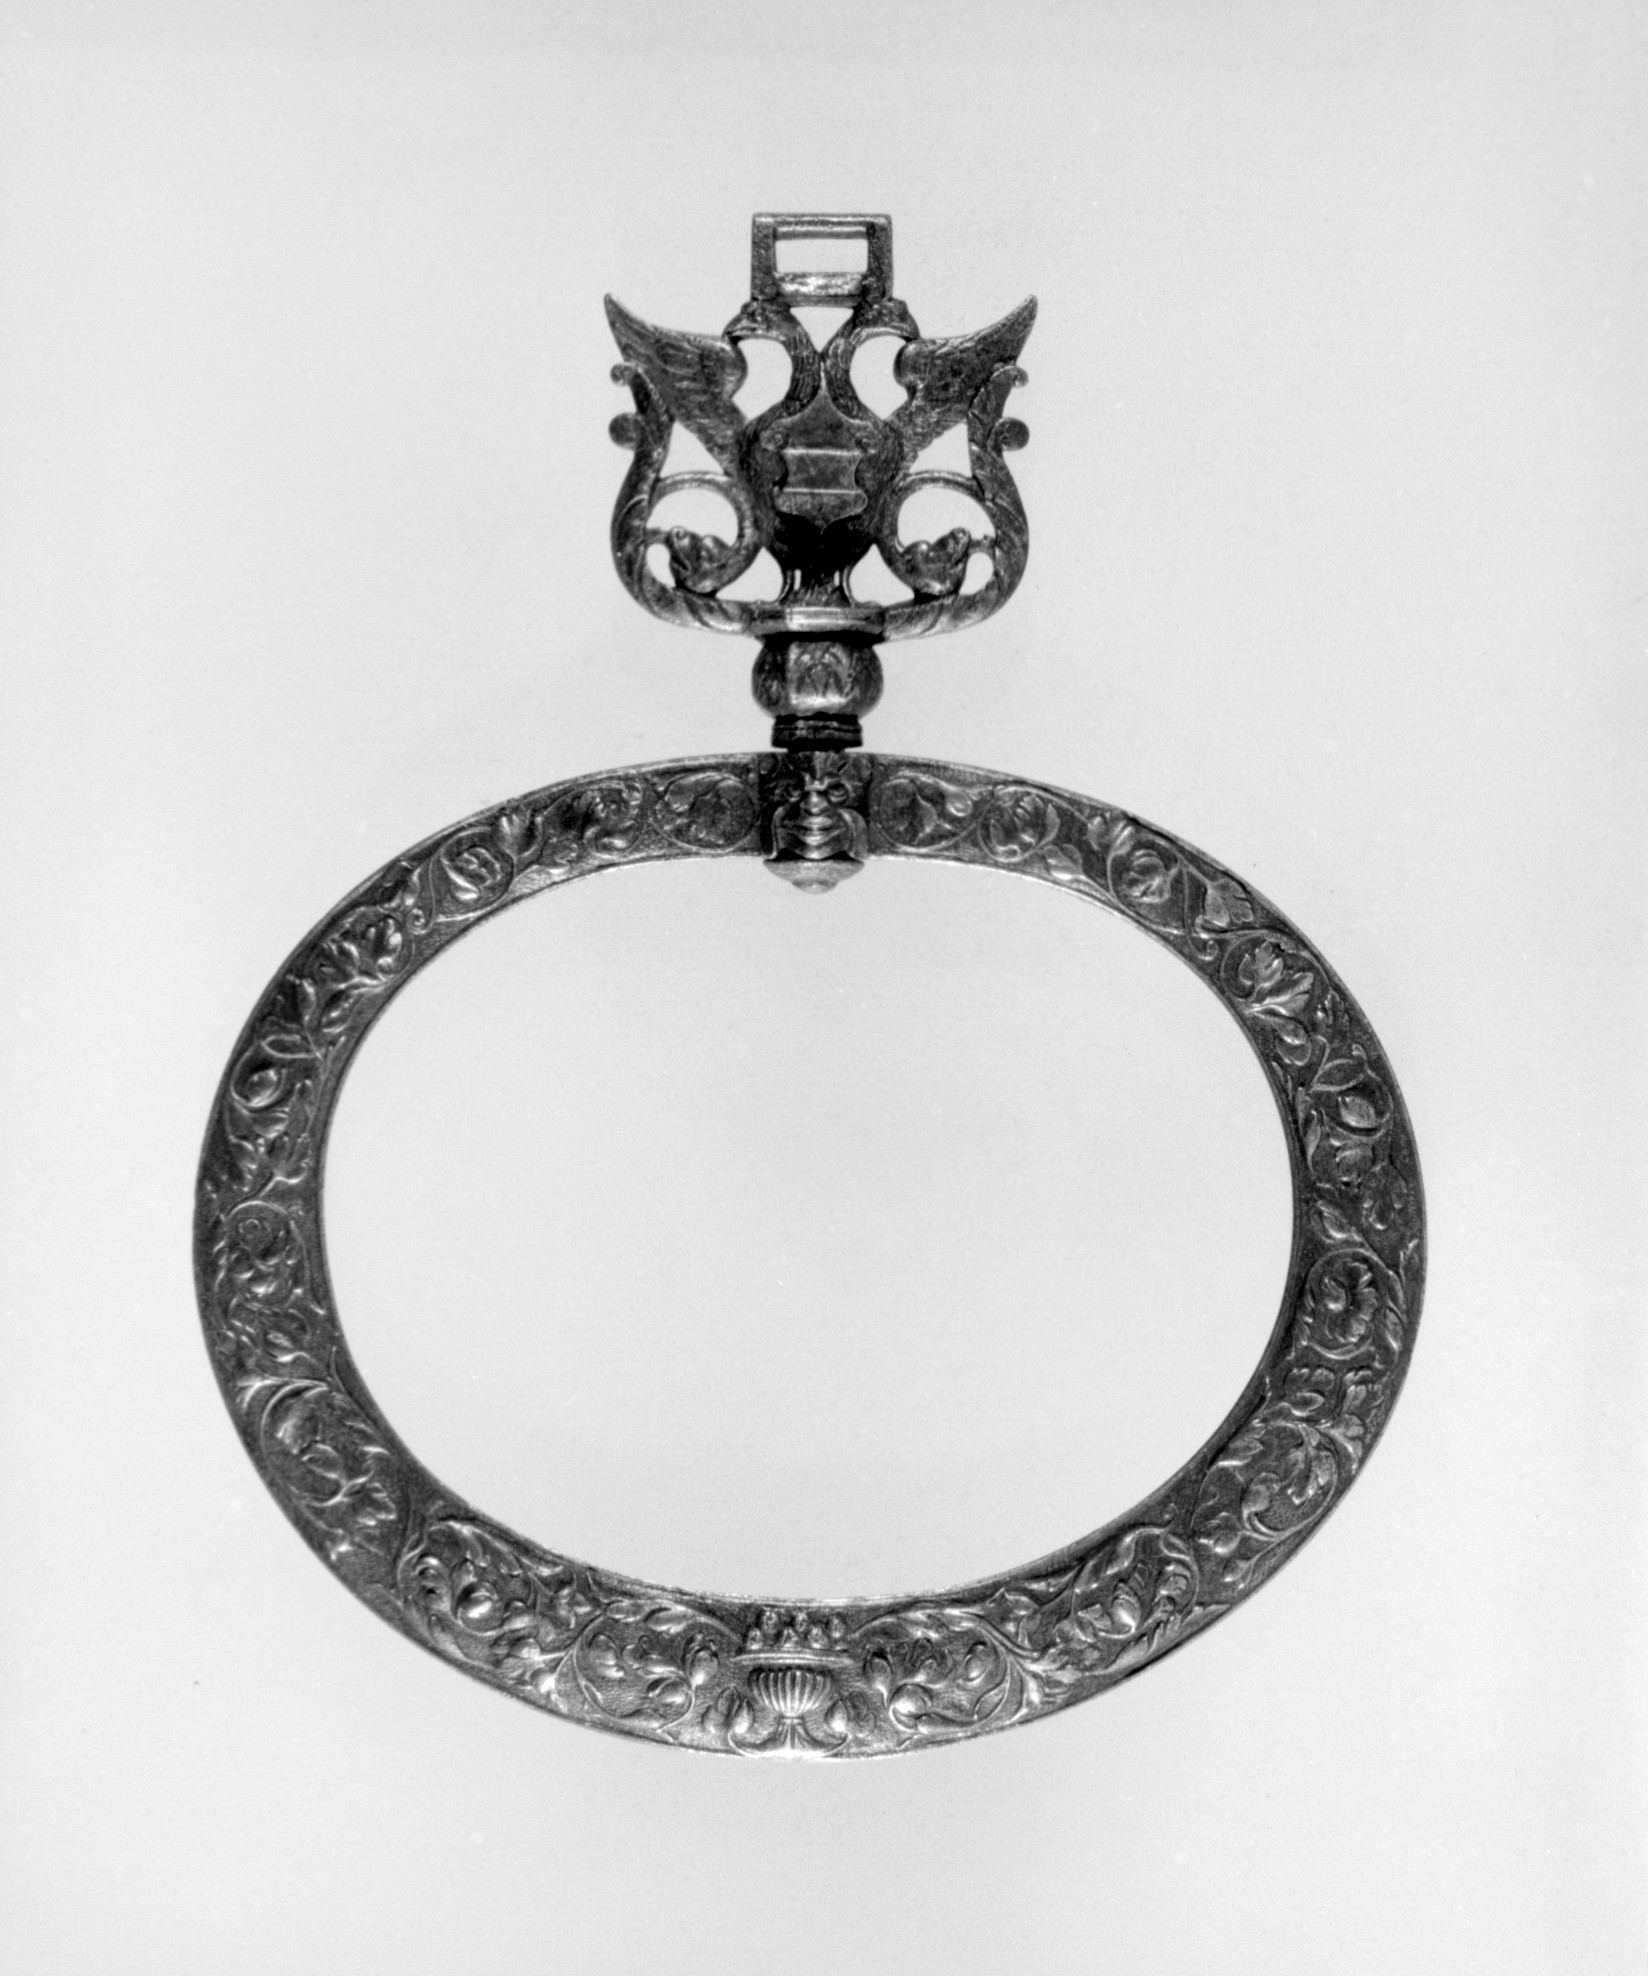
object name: purse frame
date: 1667-1700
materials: steel